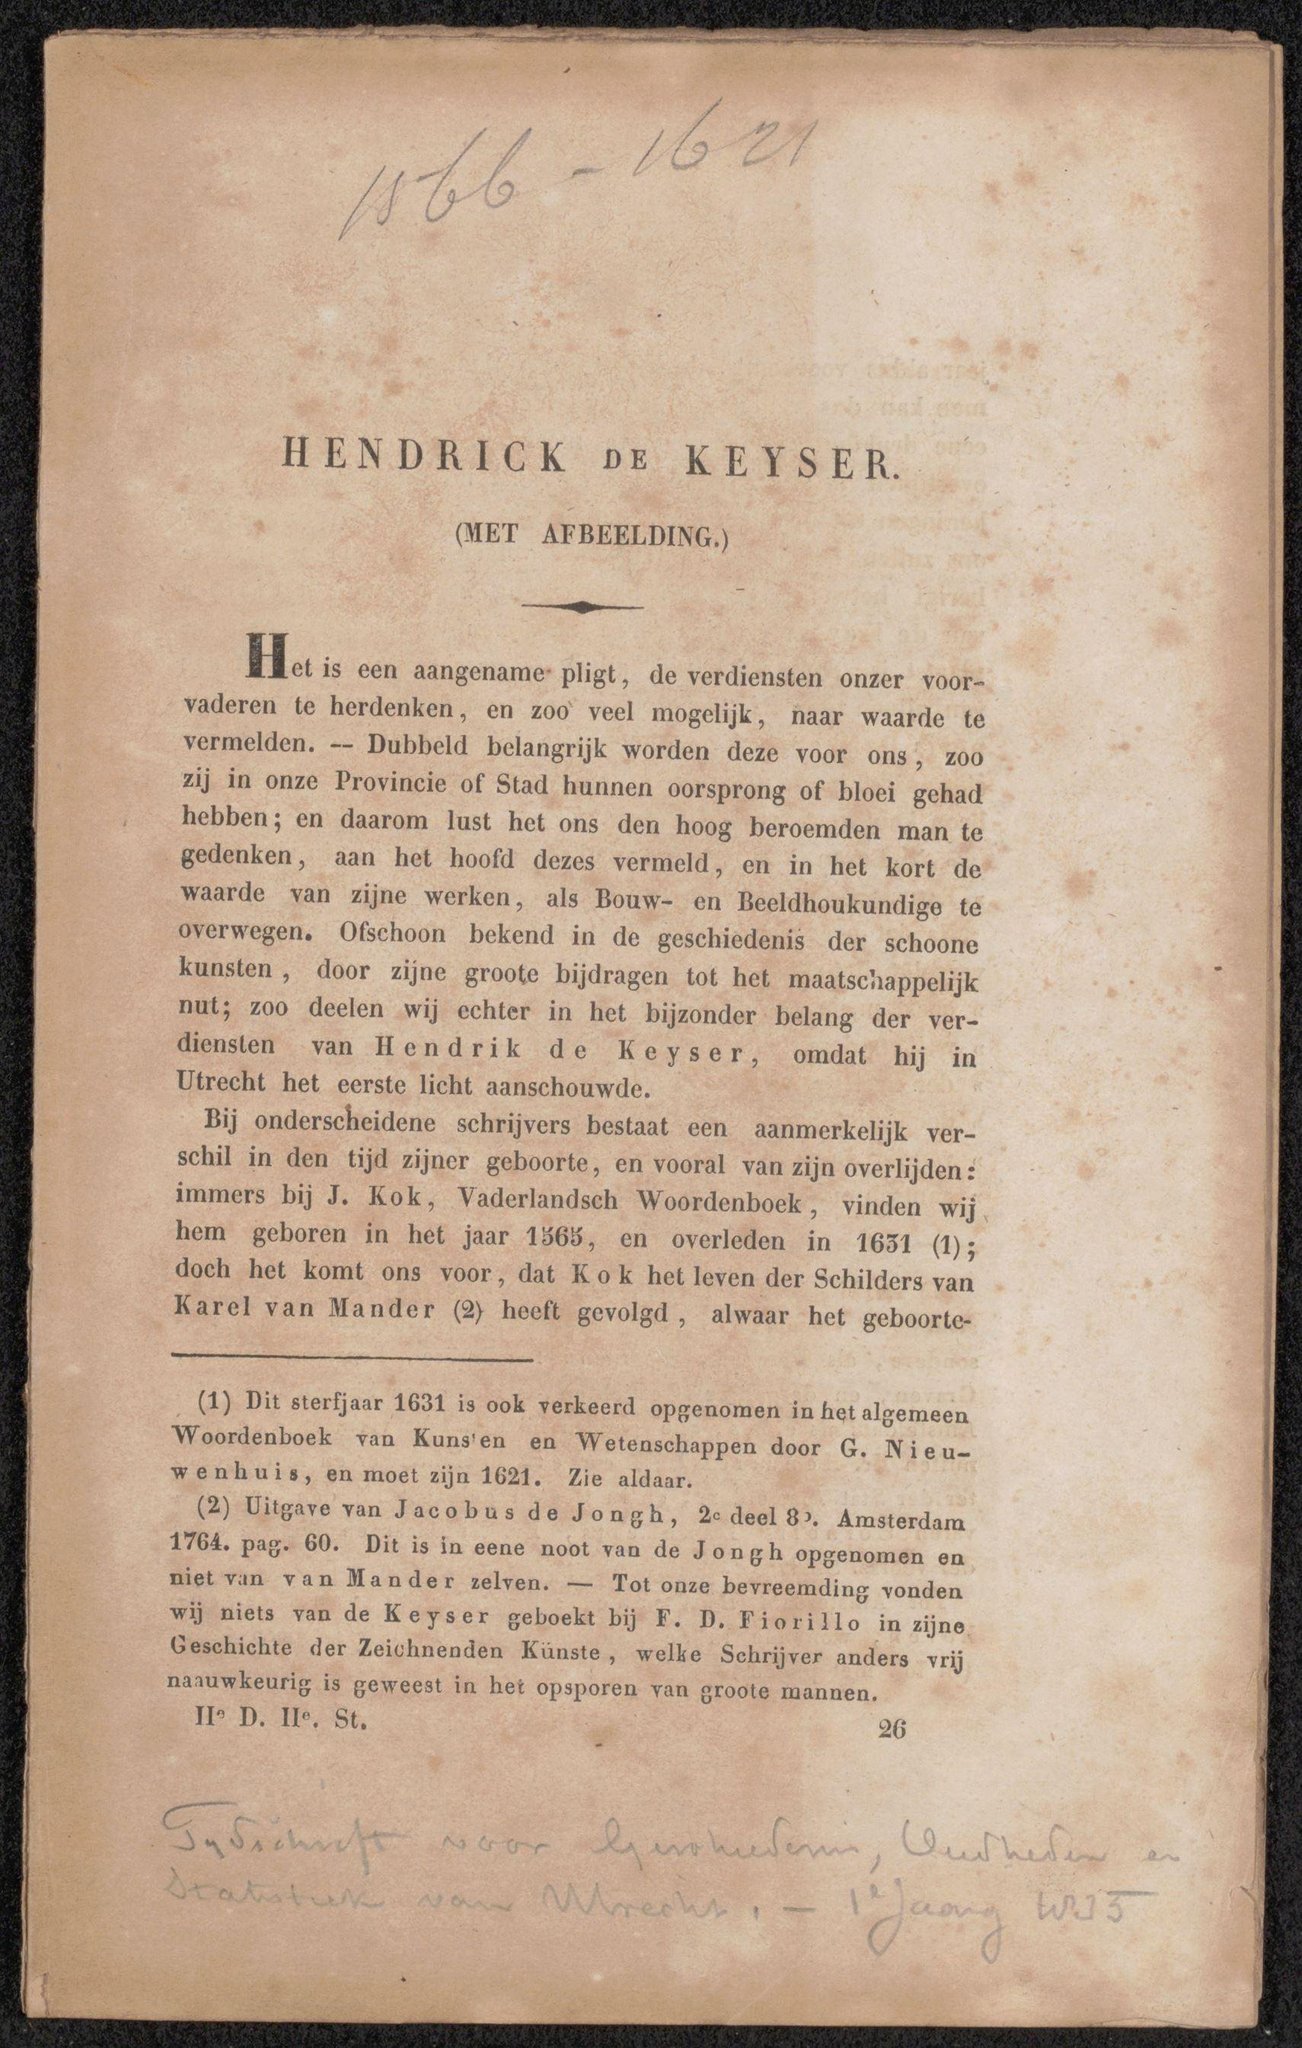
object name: article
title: Artikel betreffende Hendrick de Keyser (I)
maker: Anonymous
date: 1835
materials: paper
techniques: printing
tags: utrecht, amsterdam, print maker, sculptor, hendrick de keyser (i)